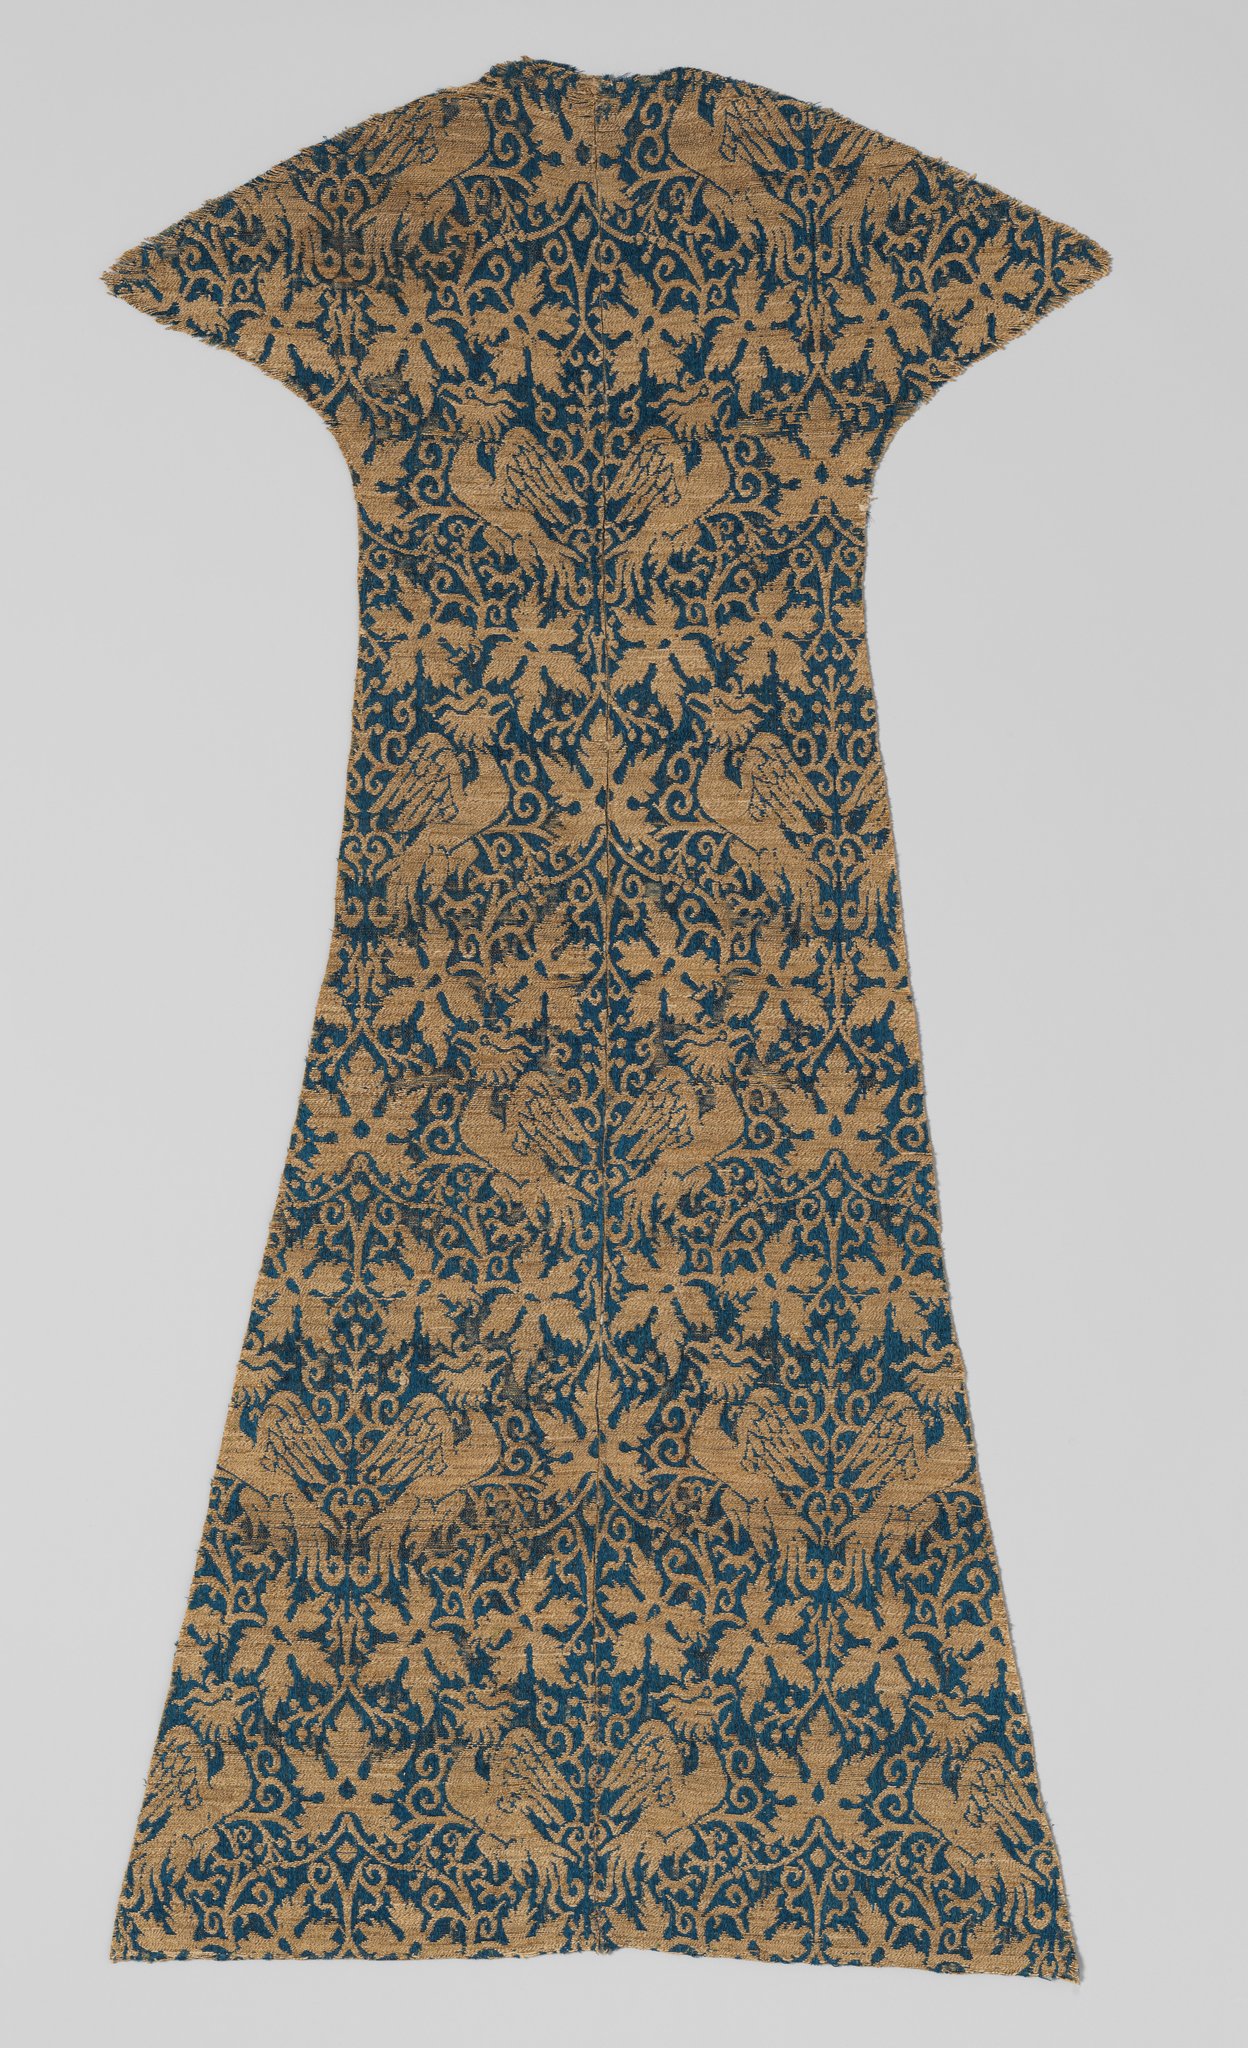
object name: textile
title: Textile with Birds, Leaves and Arabesques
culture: italian or spanish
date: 1301-1400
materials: metal thread, silk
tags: birds